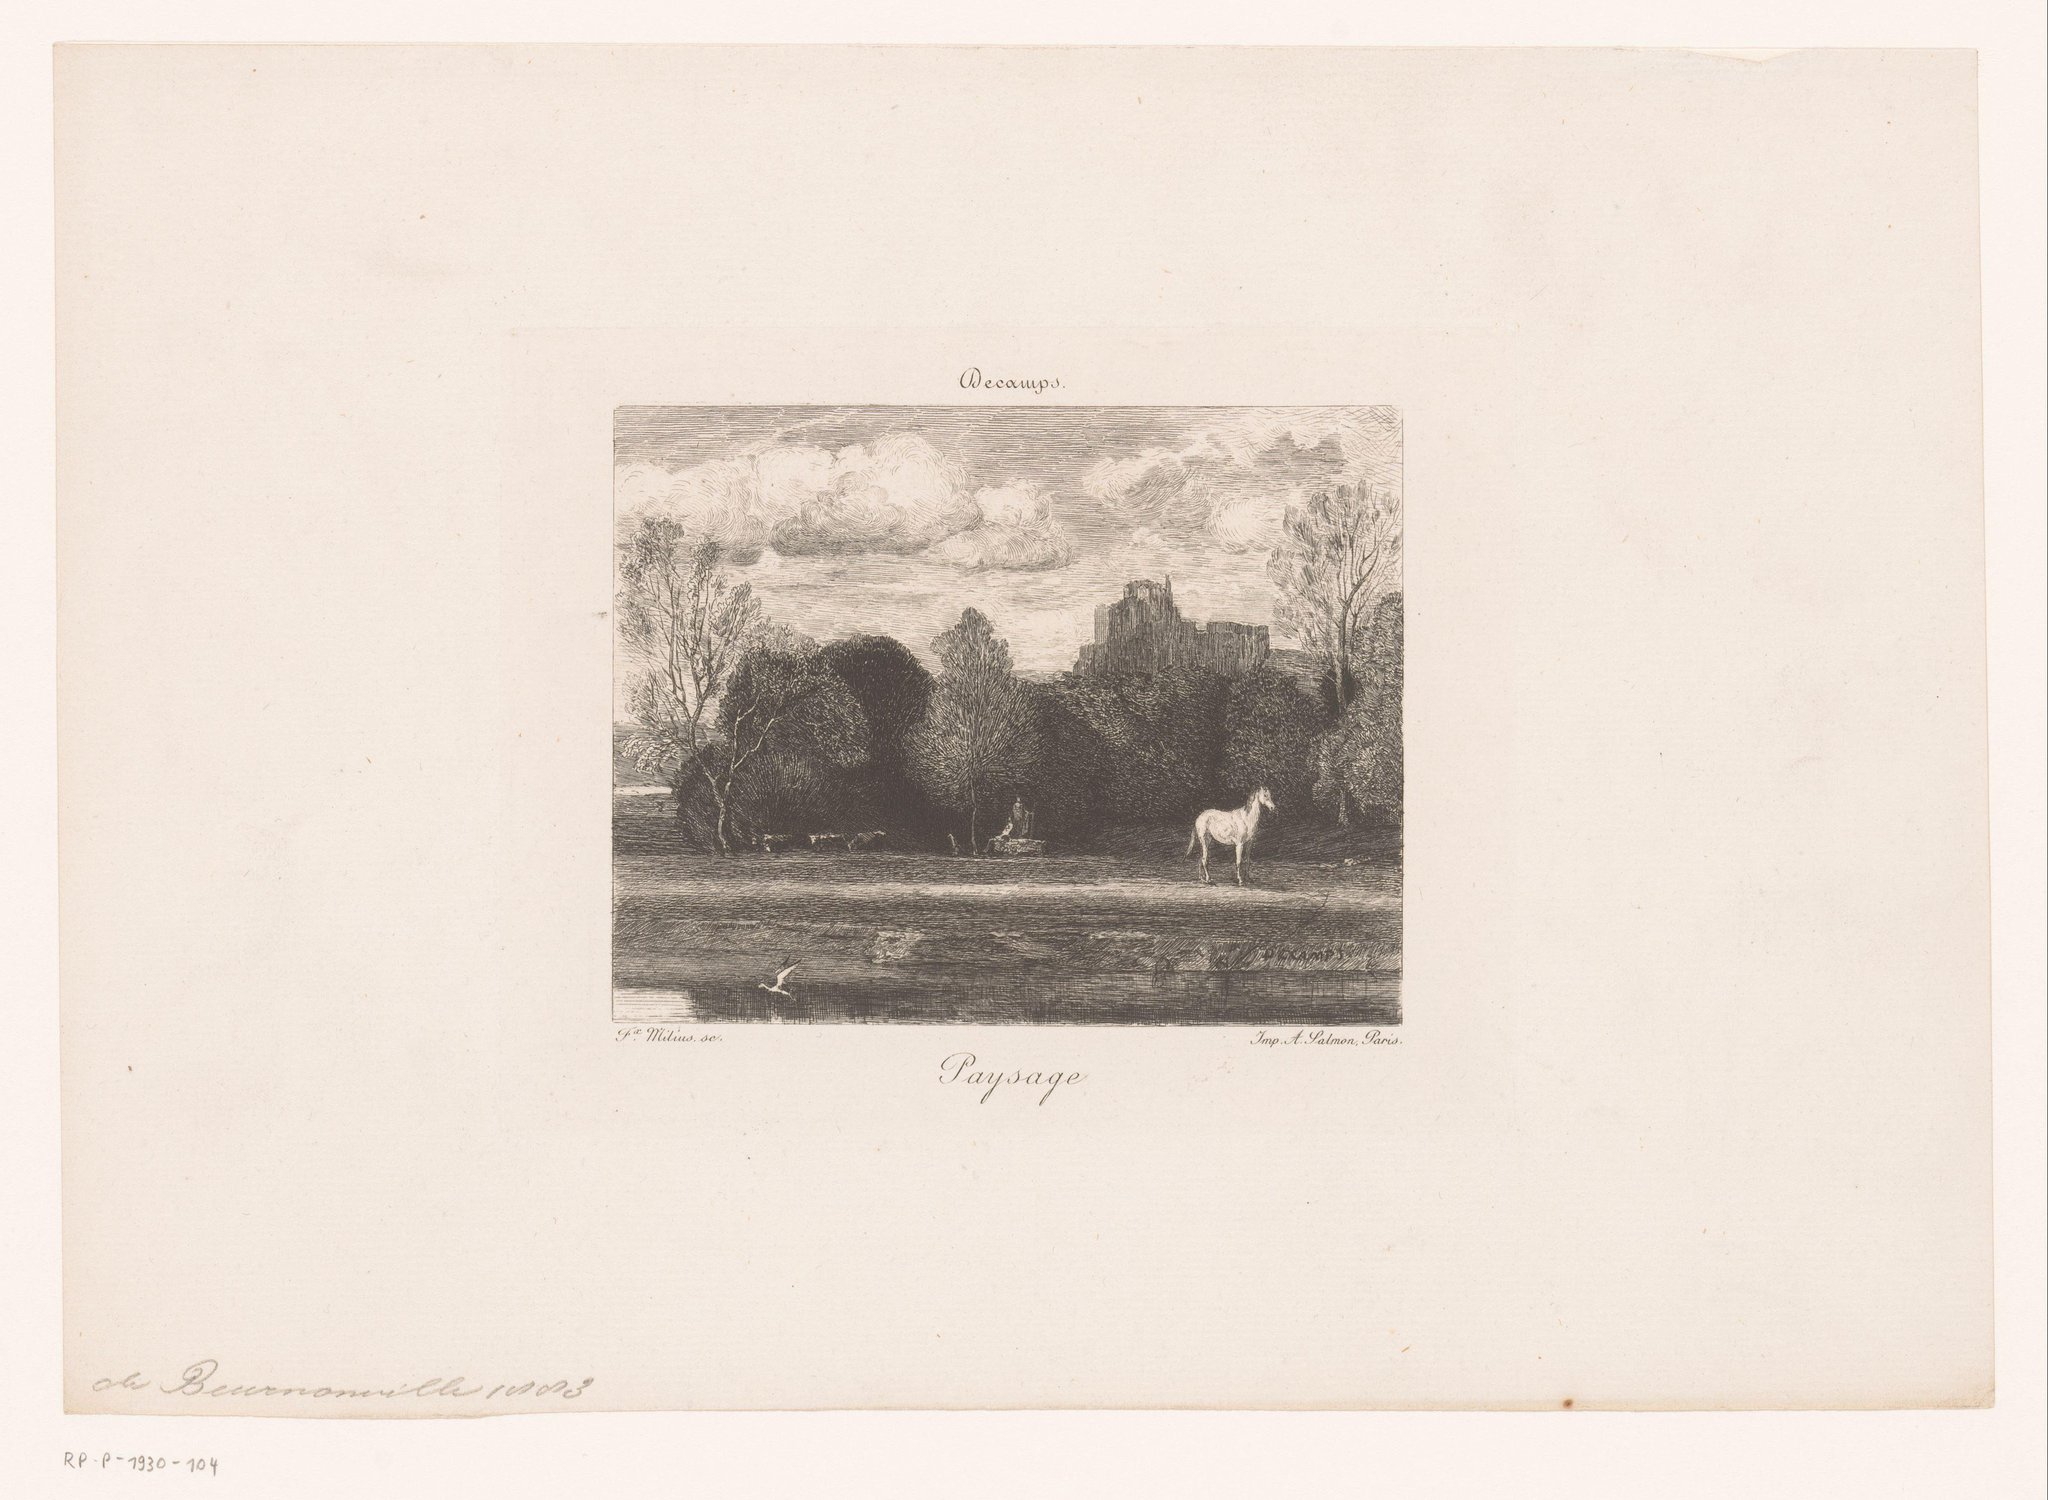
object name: print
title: Paysage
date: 1853-1894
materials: paper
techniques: engraving, etching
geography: paris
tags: landscapes, horse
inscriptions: collector's mark: Lugt 2228, watermark